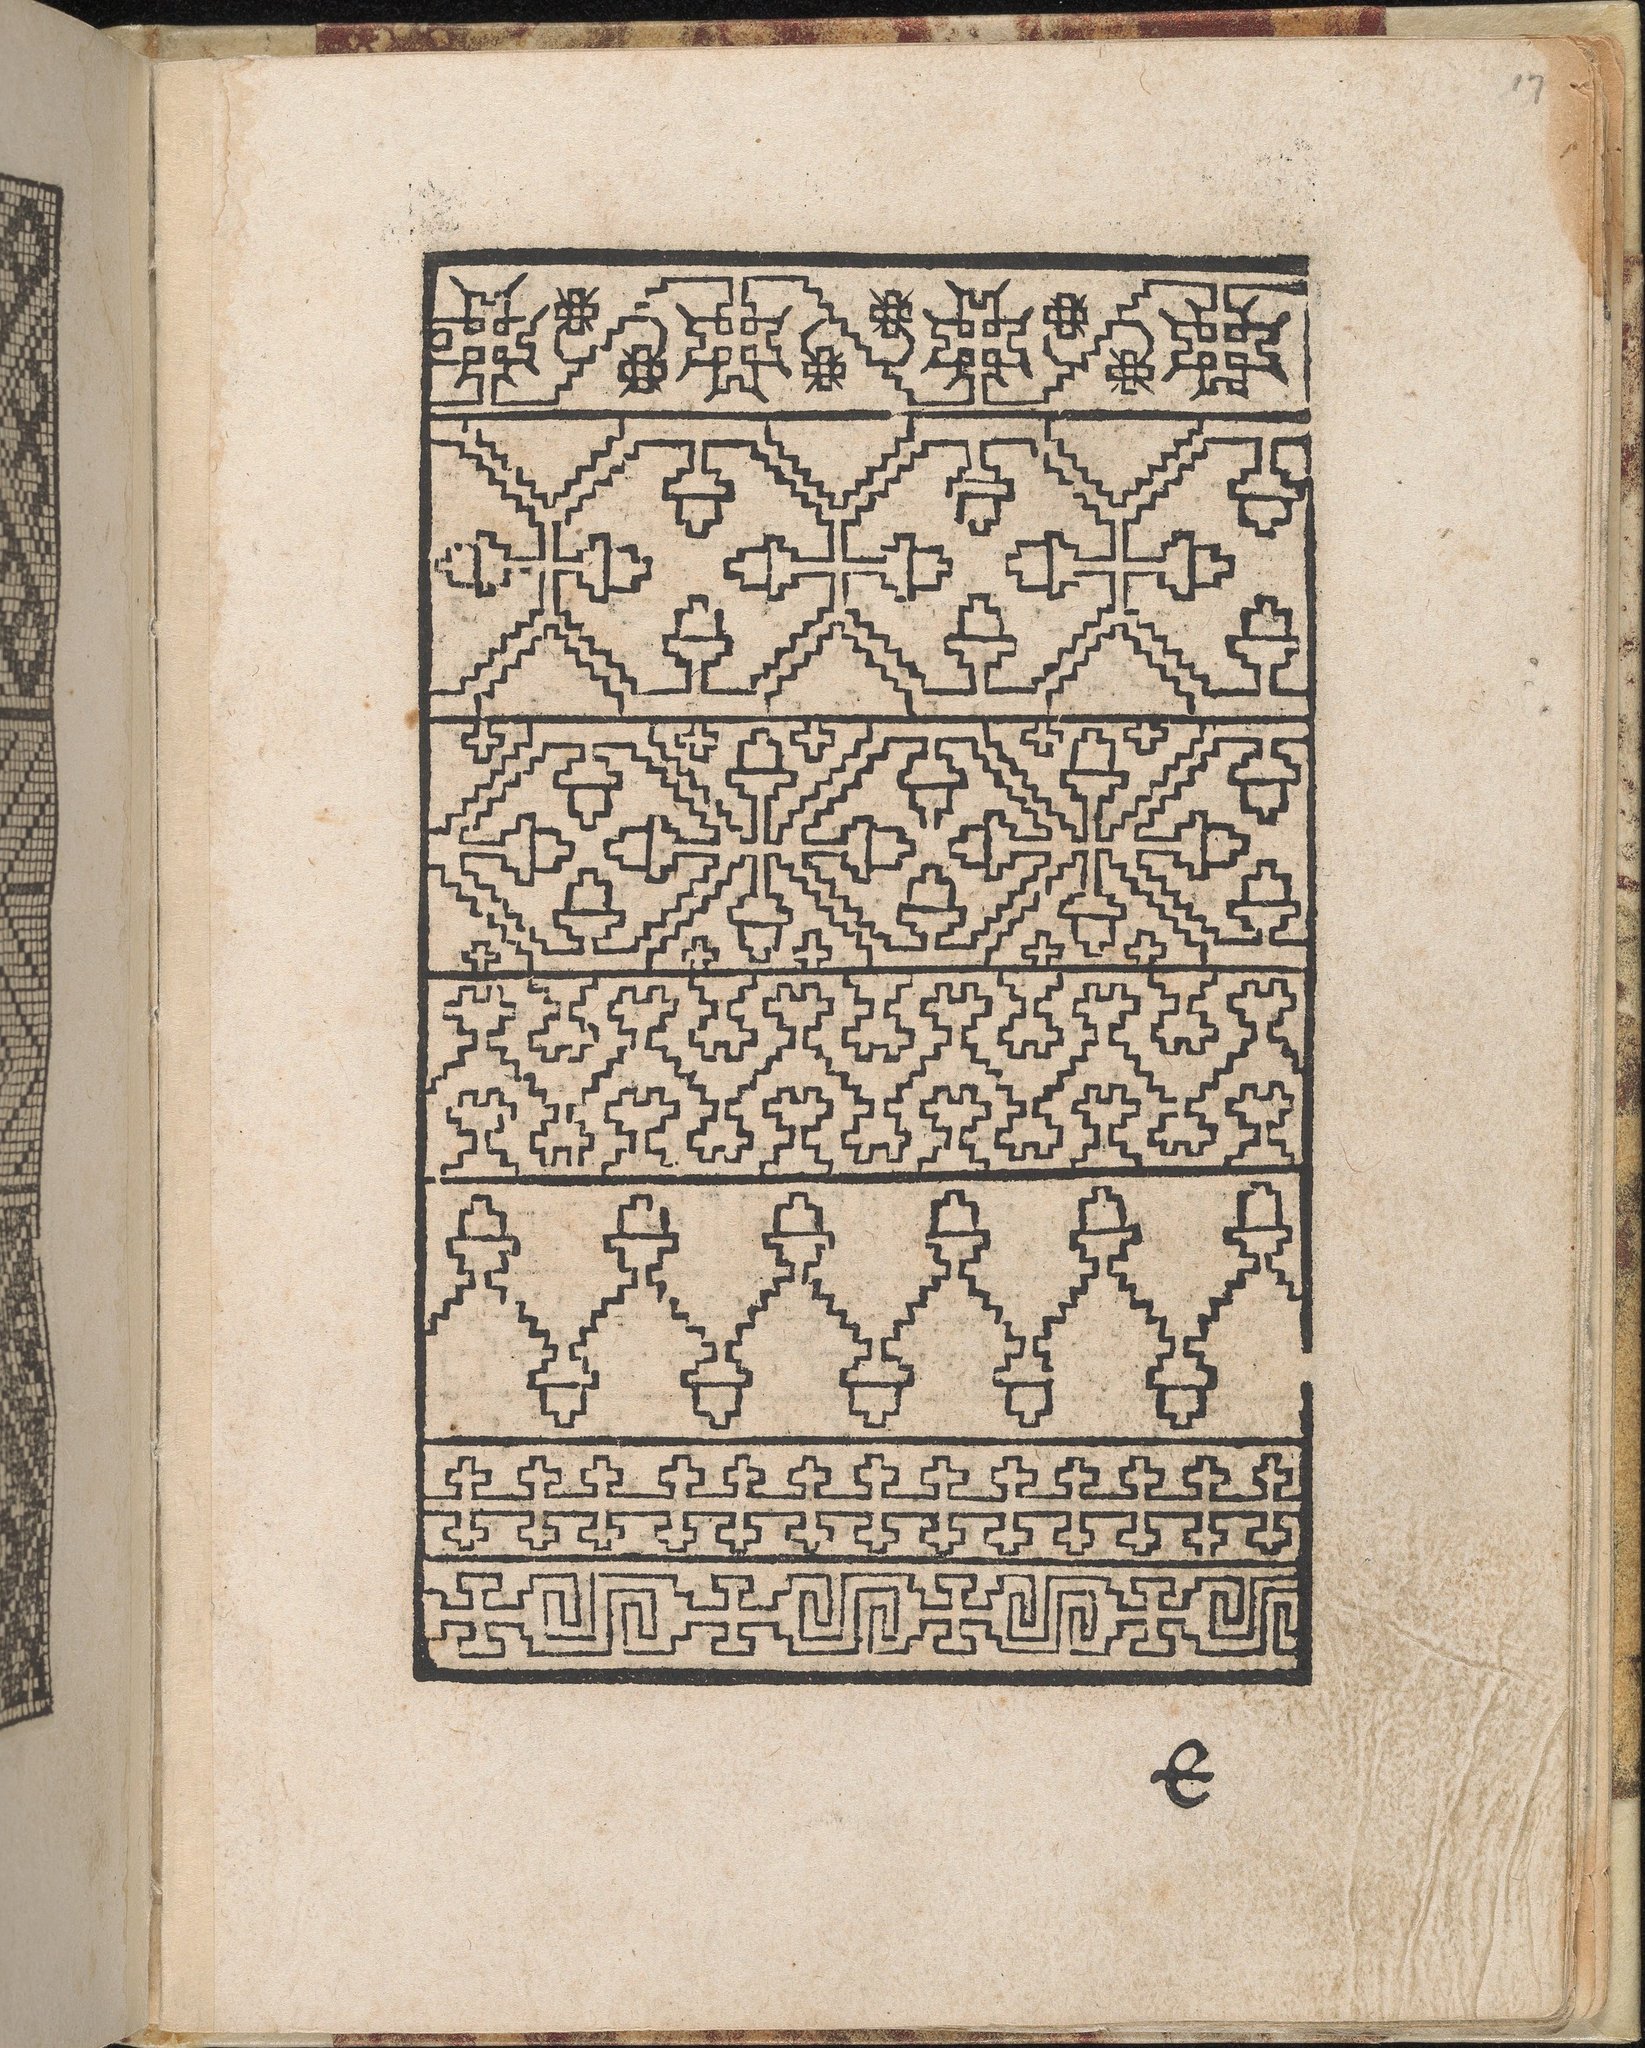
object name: book print ornament architecture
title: Ein new getruckt model Büchli...Page 17, recto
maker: johann schönsperger the younger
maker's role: publisher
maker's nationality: german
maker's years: 1490-1550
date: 1529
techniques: woodcut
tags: ornament